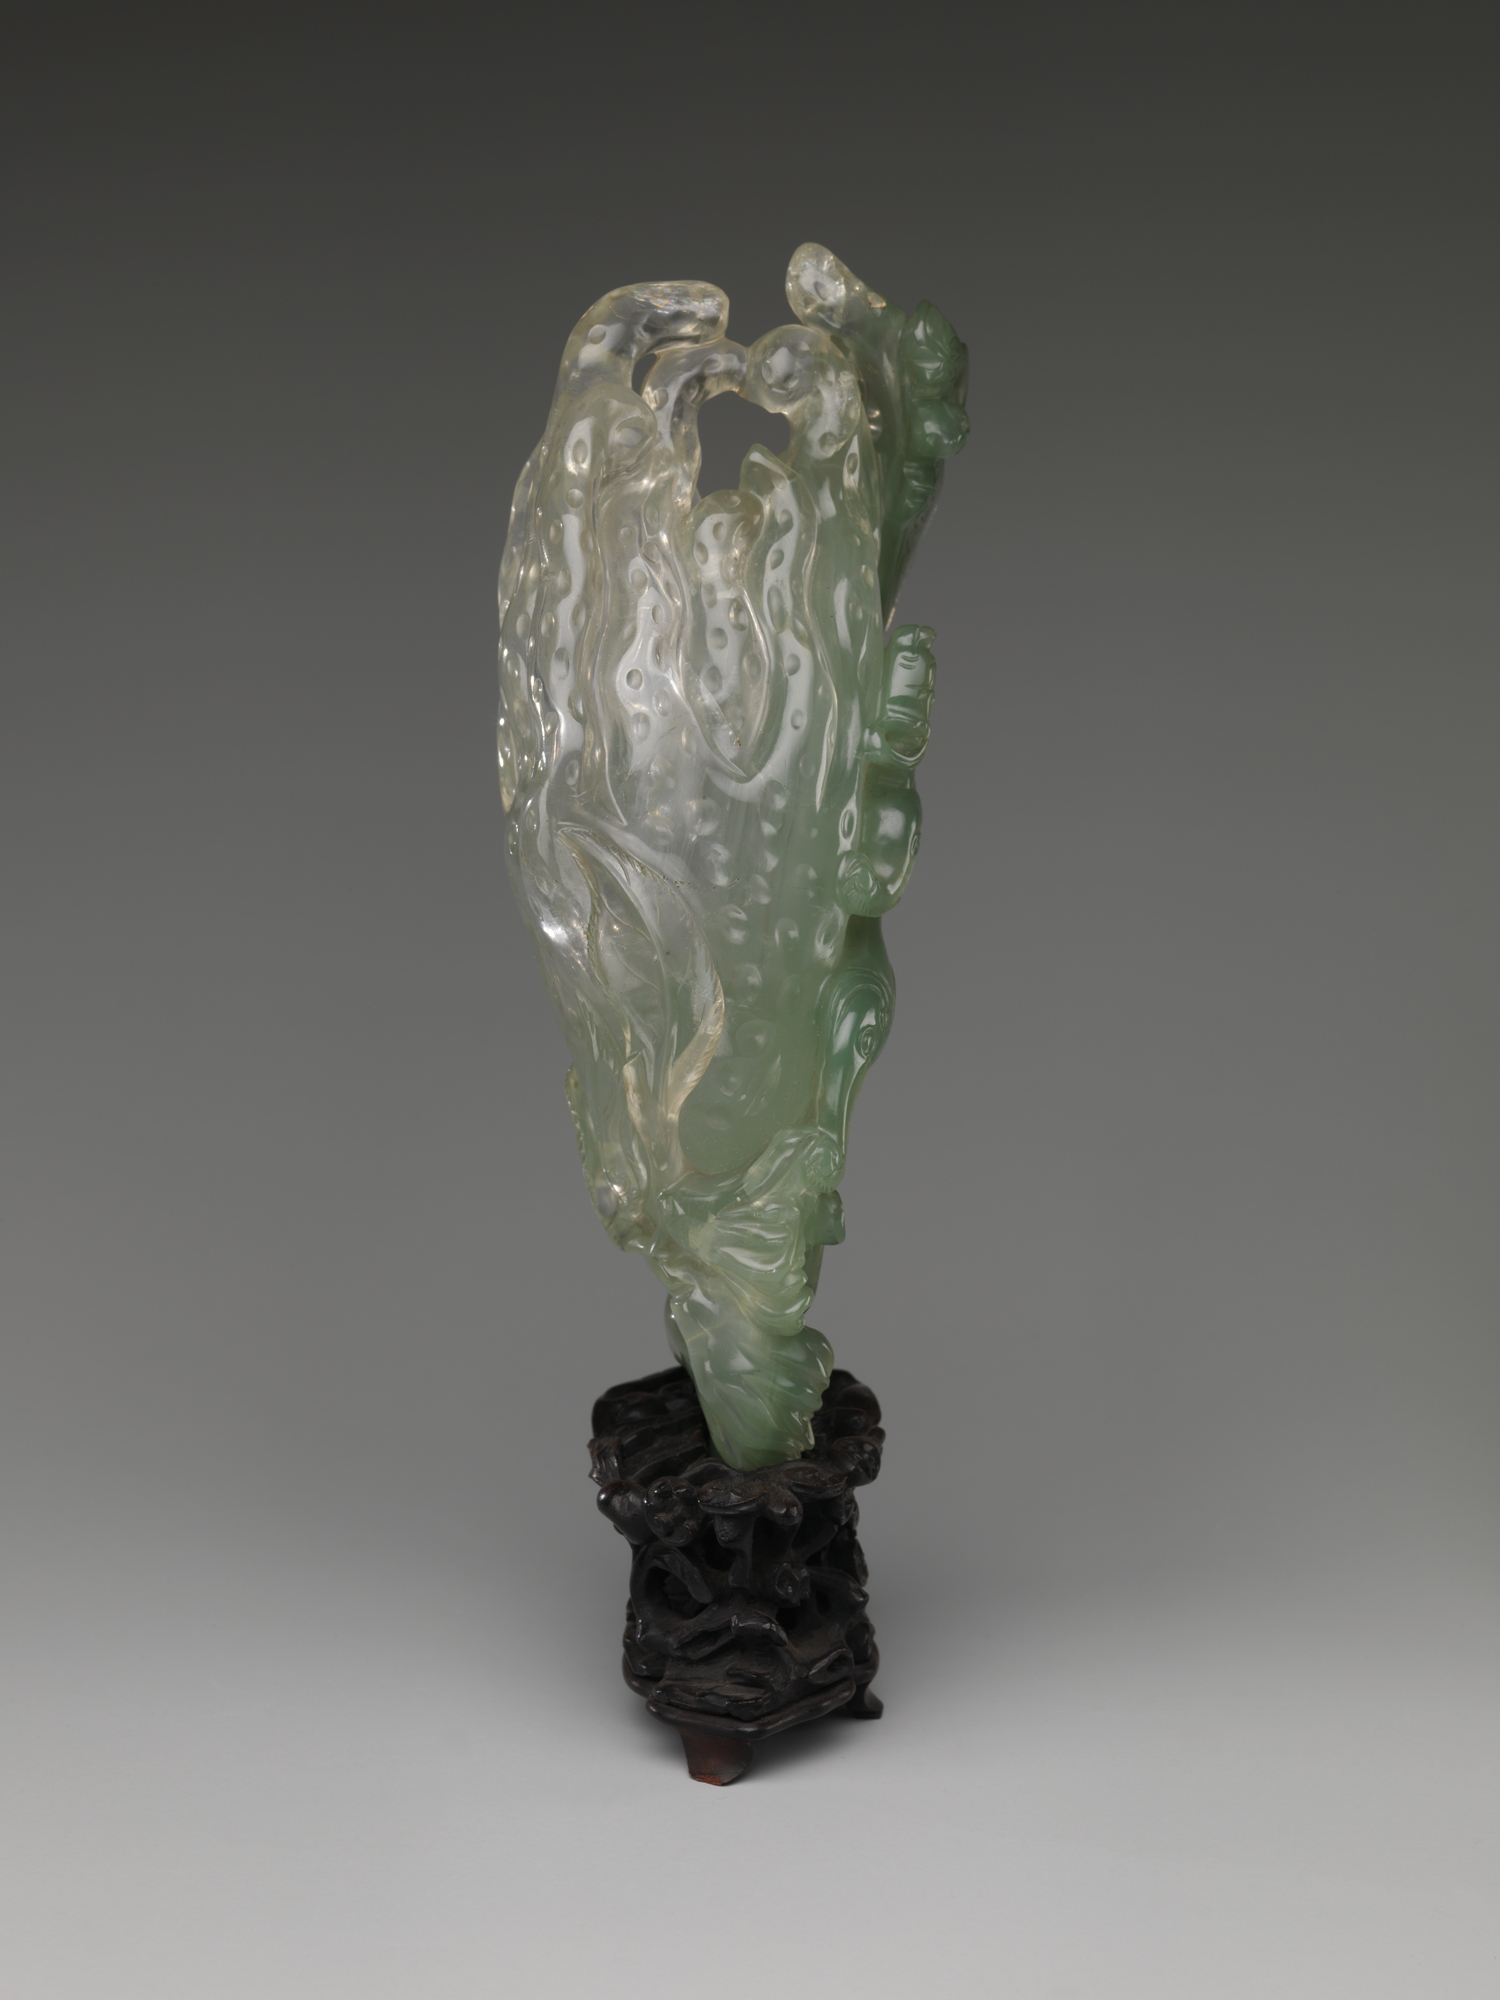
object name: carving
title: Buddha’s Hand with Dragon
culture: chinese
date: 1701-1800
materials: quartz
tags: dragons